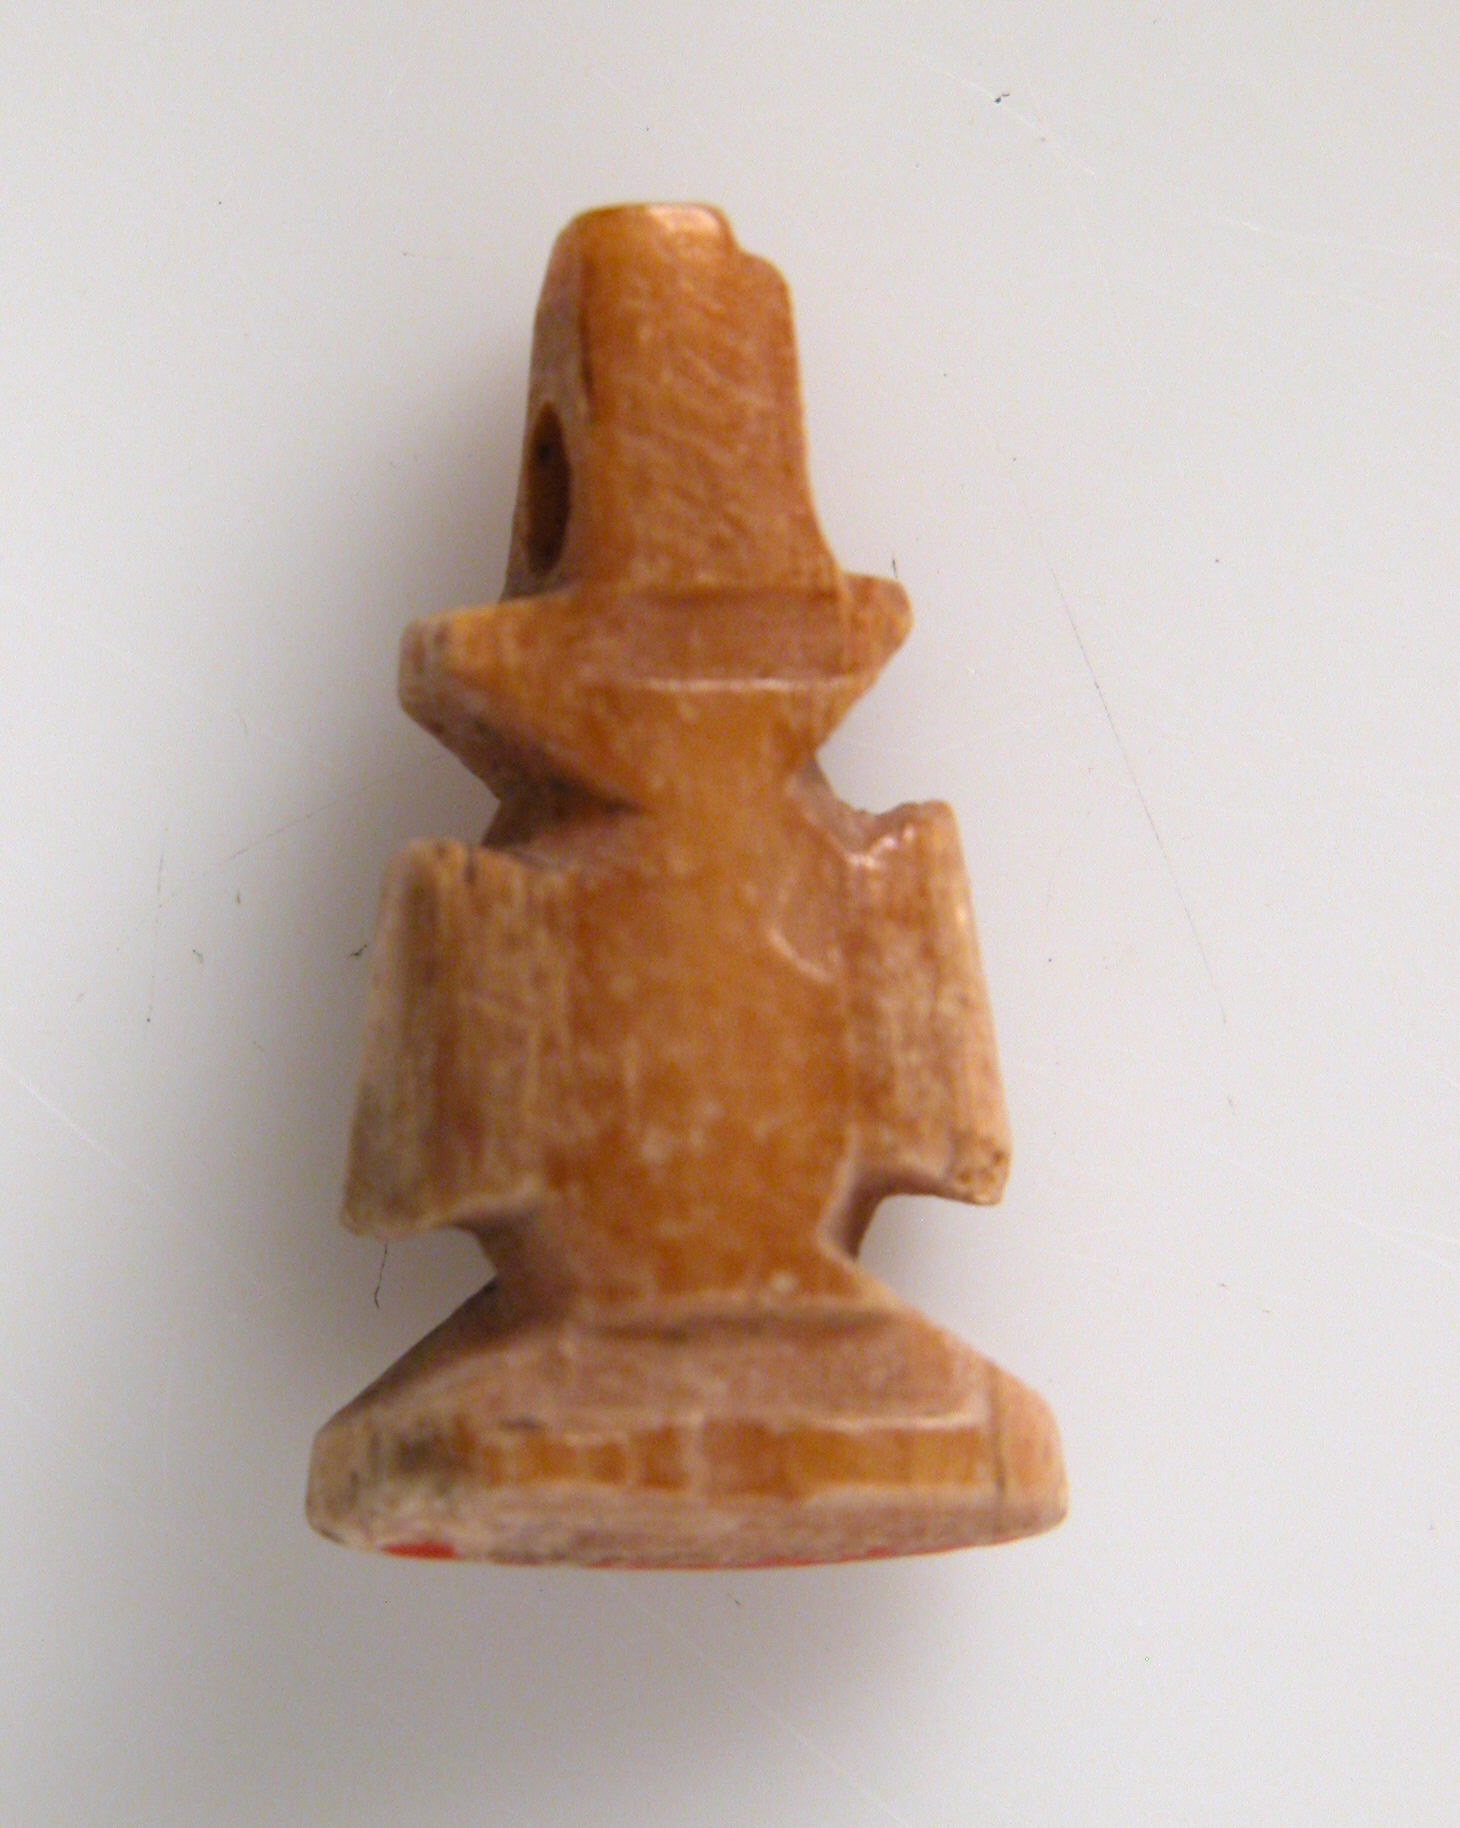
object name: pendant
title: Pendant Cross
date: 401-700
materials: bone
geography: egypt